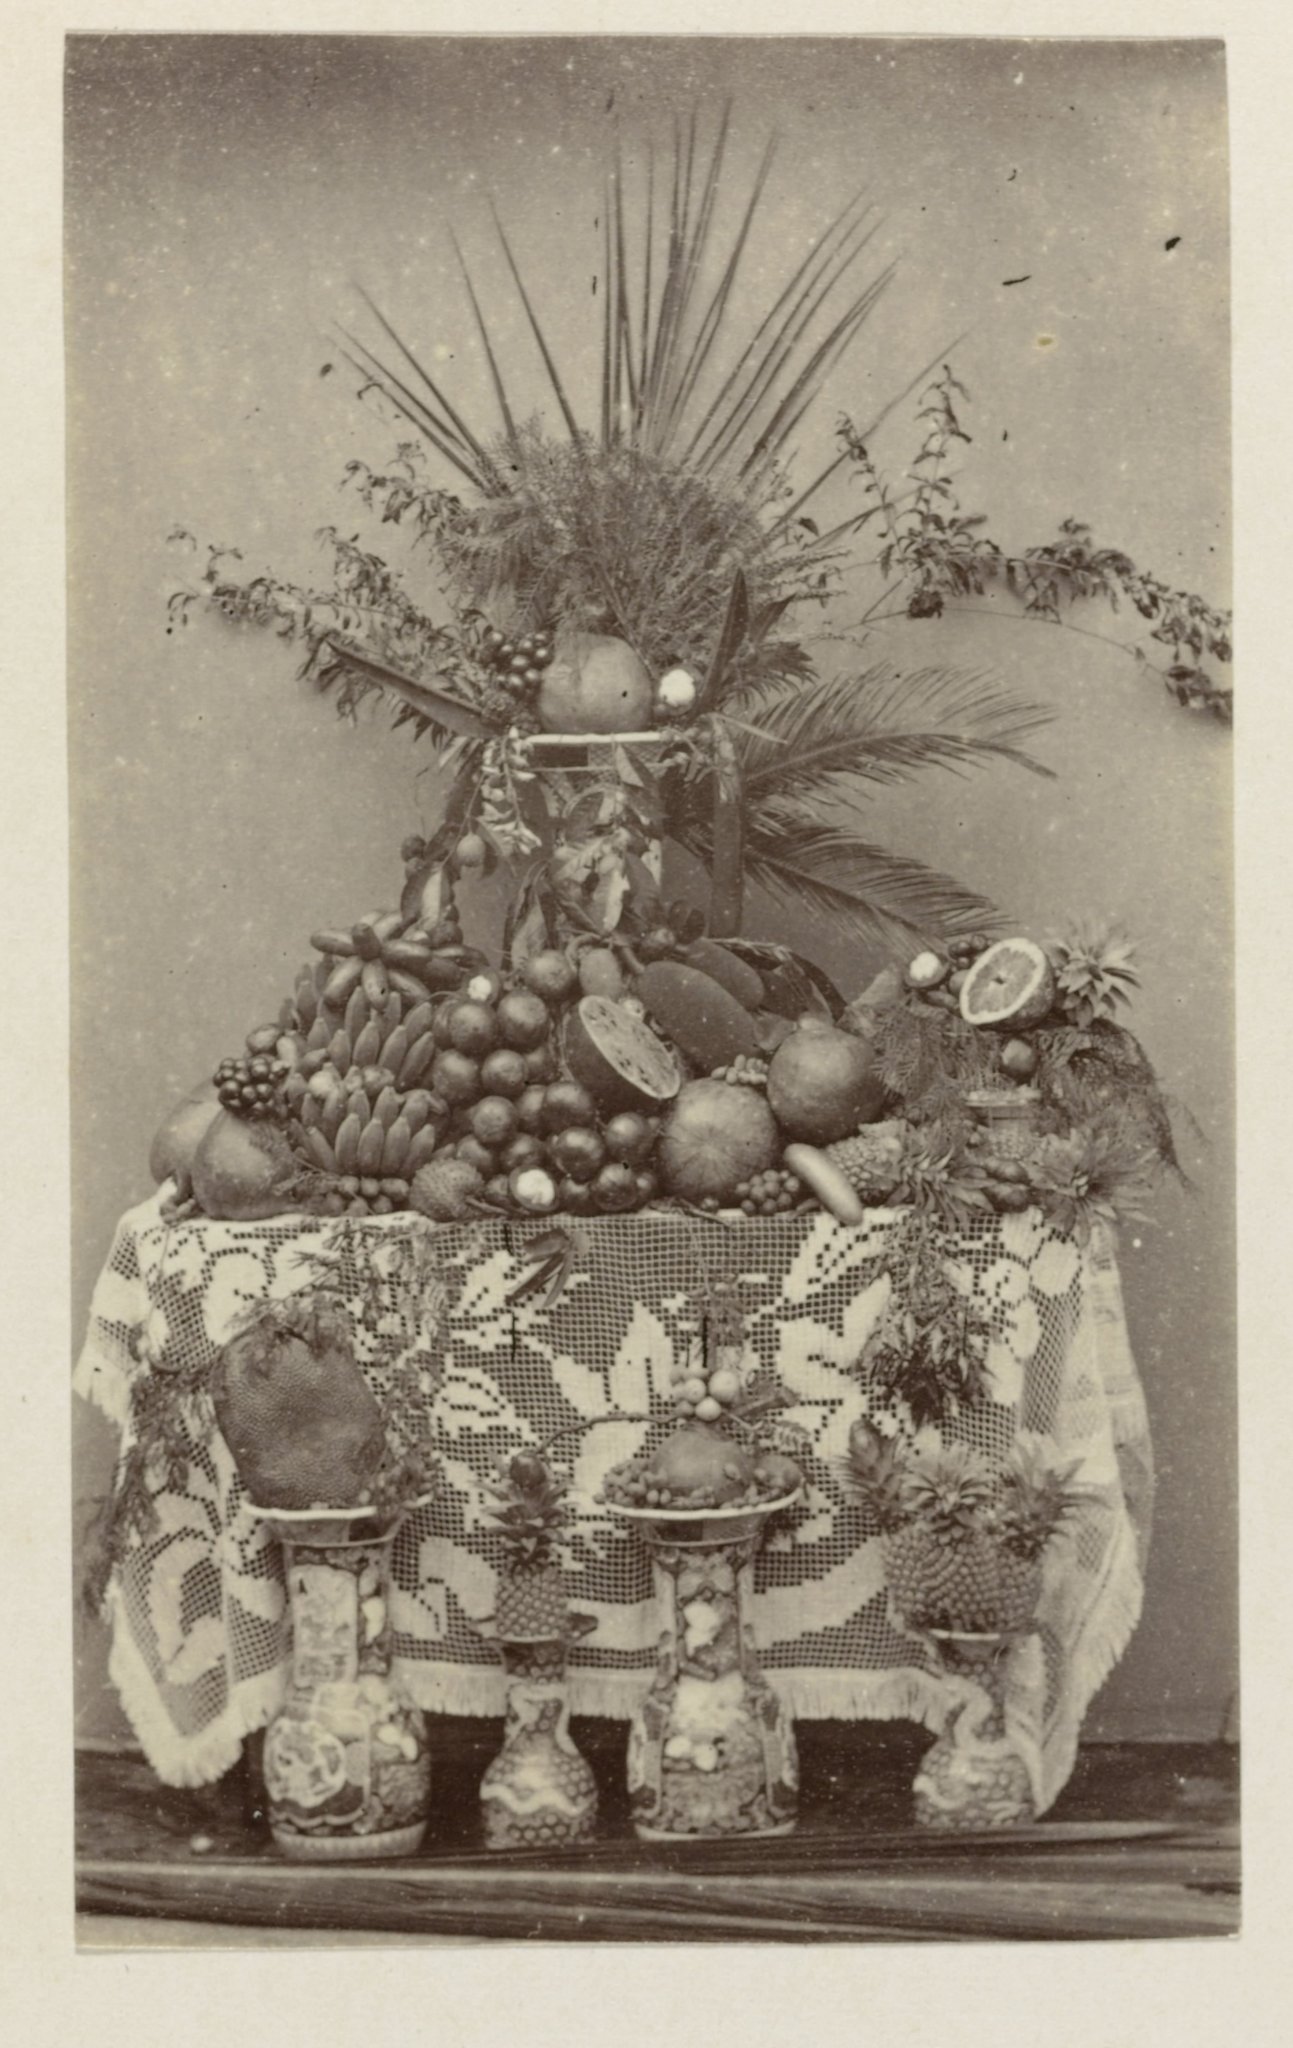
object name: photograph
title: Stilleven van tropische vruchten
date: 1870-1880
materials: photographic support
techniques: albumen print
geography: batavia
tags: fruit, java, batavia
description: Stilleven van tropische vruchten op een tafeltje met een kleed, voor de tafel staan vier vazen met fruit. Ingeplakte foto in het fotoalbum getiteld: Gezichten van Java.